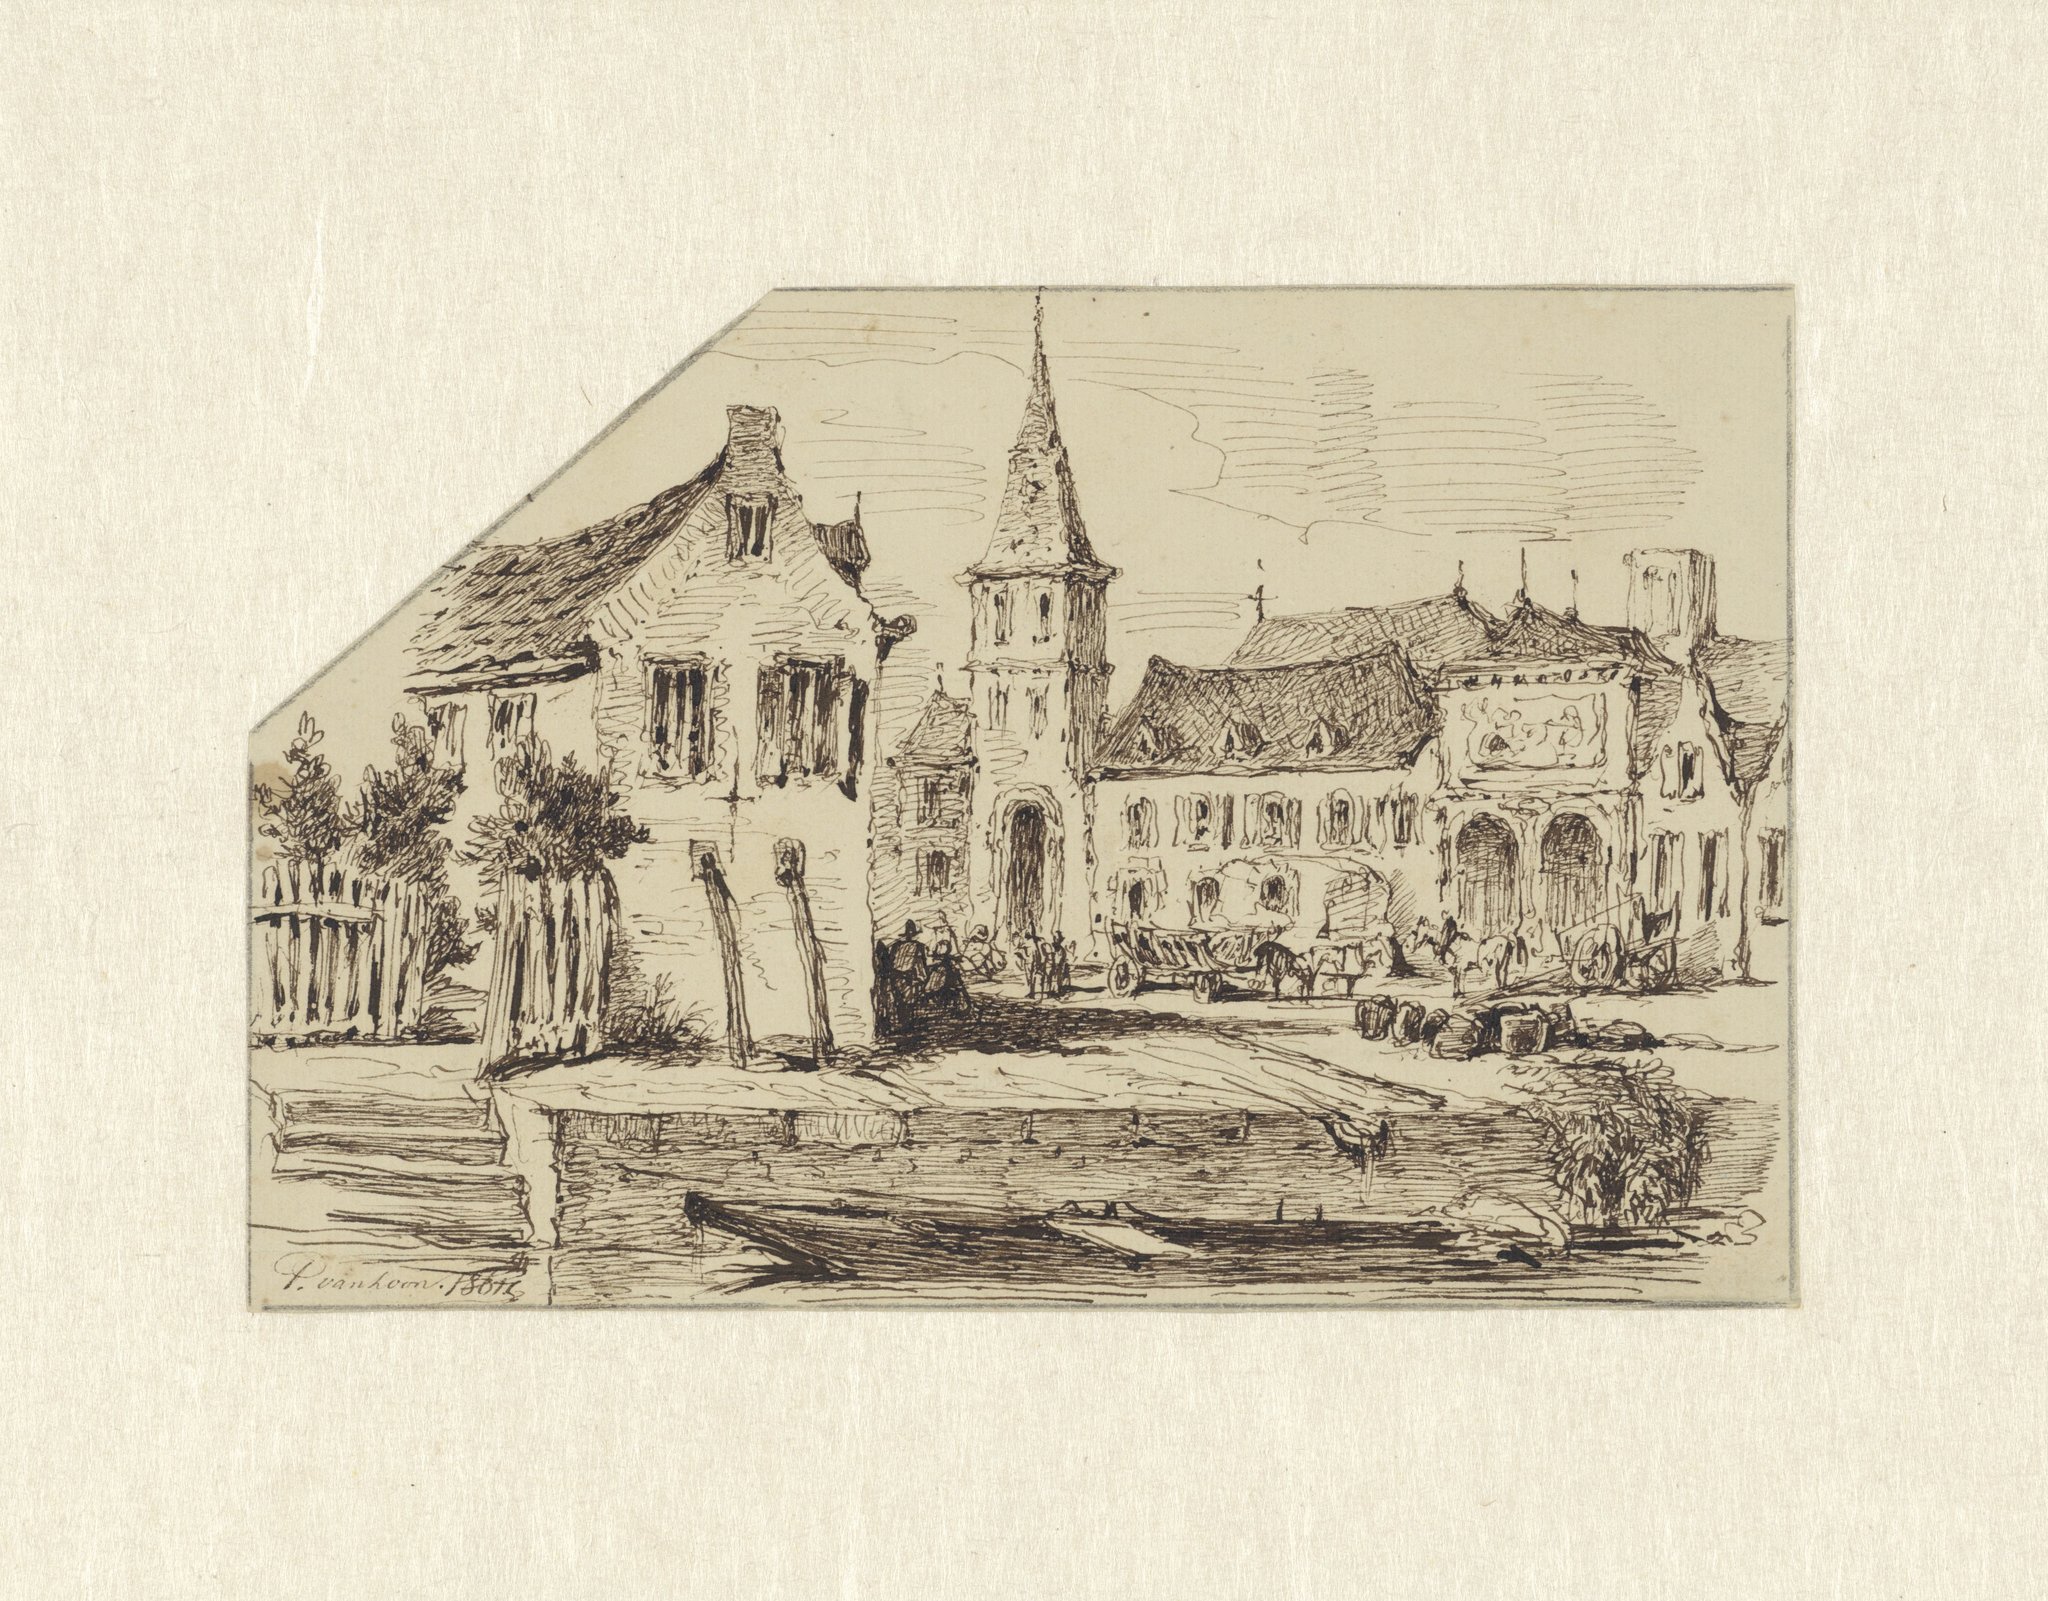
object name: drawing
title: Gezicht in een Duits stadje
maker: pieter van loon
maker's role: draughtsman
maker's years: 1801-1873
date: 1861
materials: ink, paper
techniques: pen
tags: germany